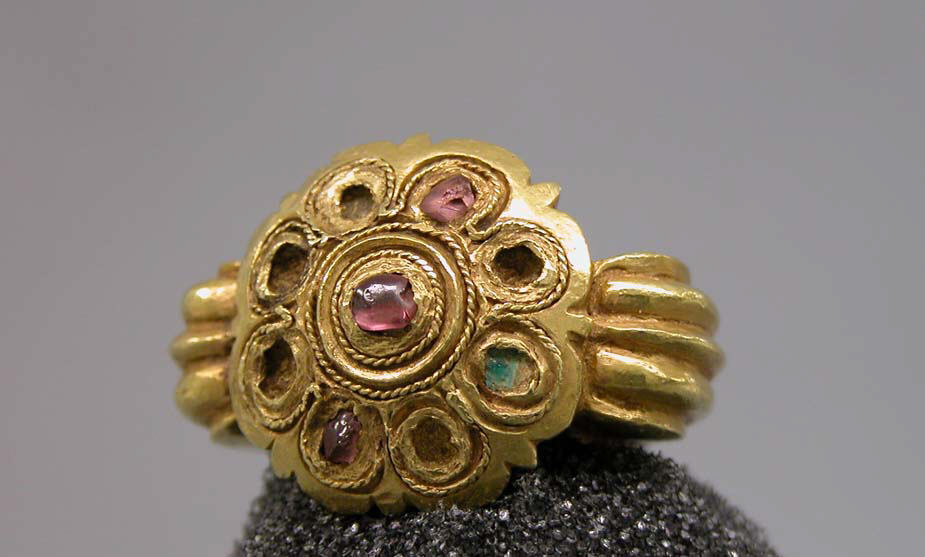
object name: ring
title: Stirrup-Shaped Ring with Stones Set in Circular Bezel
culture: indonesian, javanese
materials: gold, stone